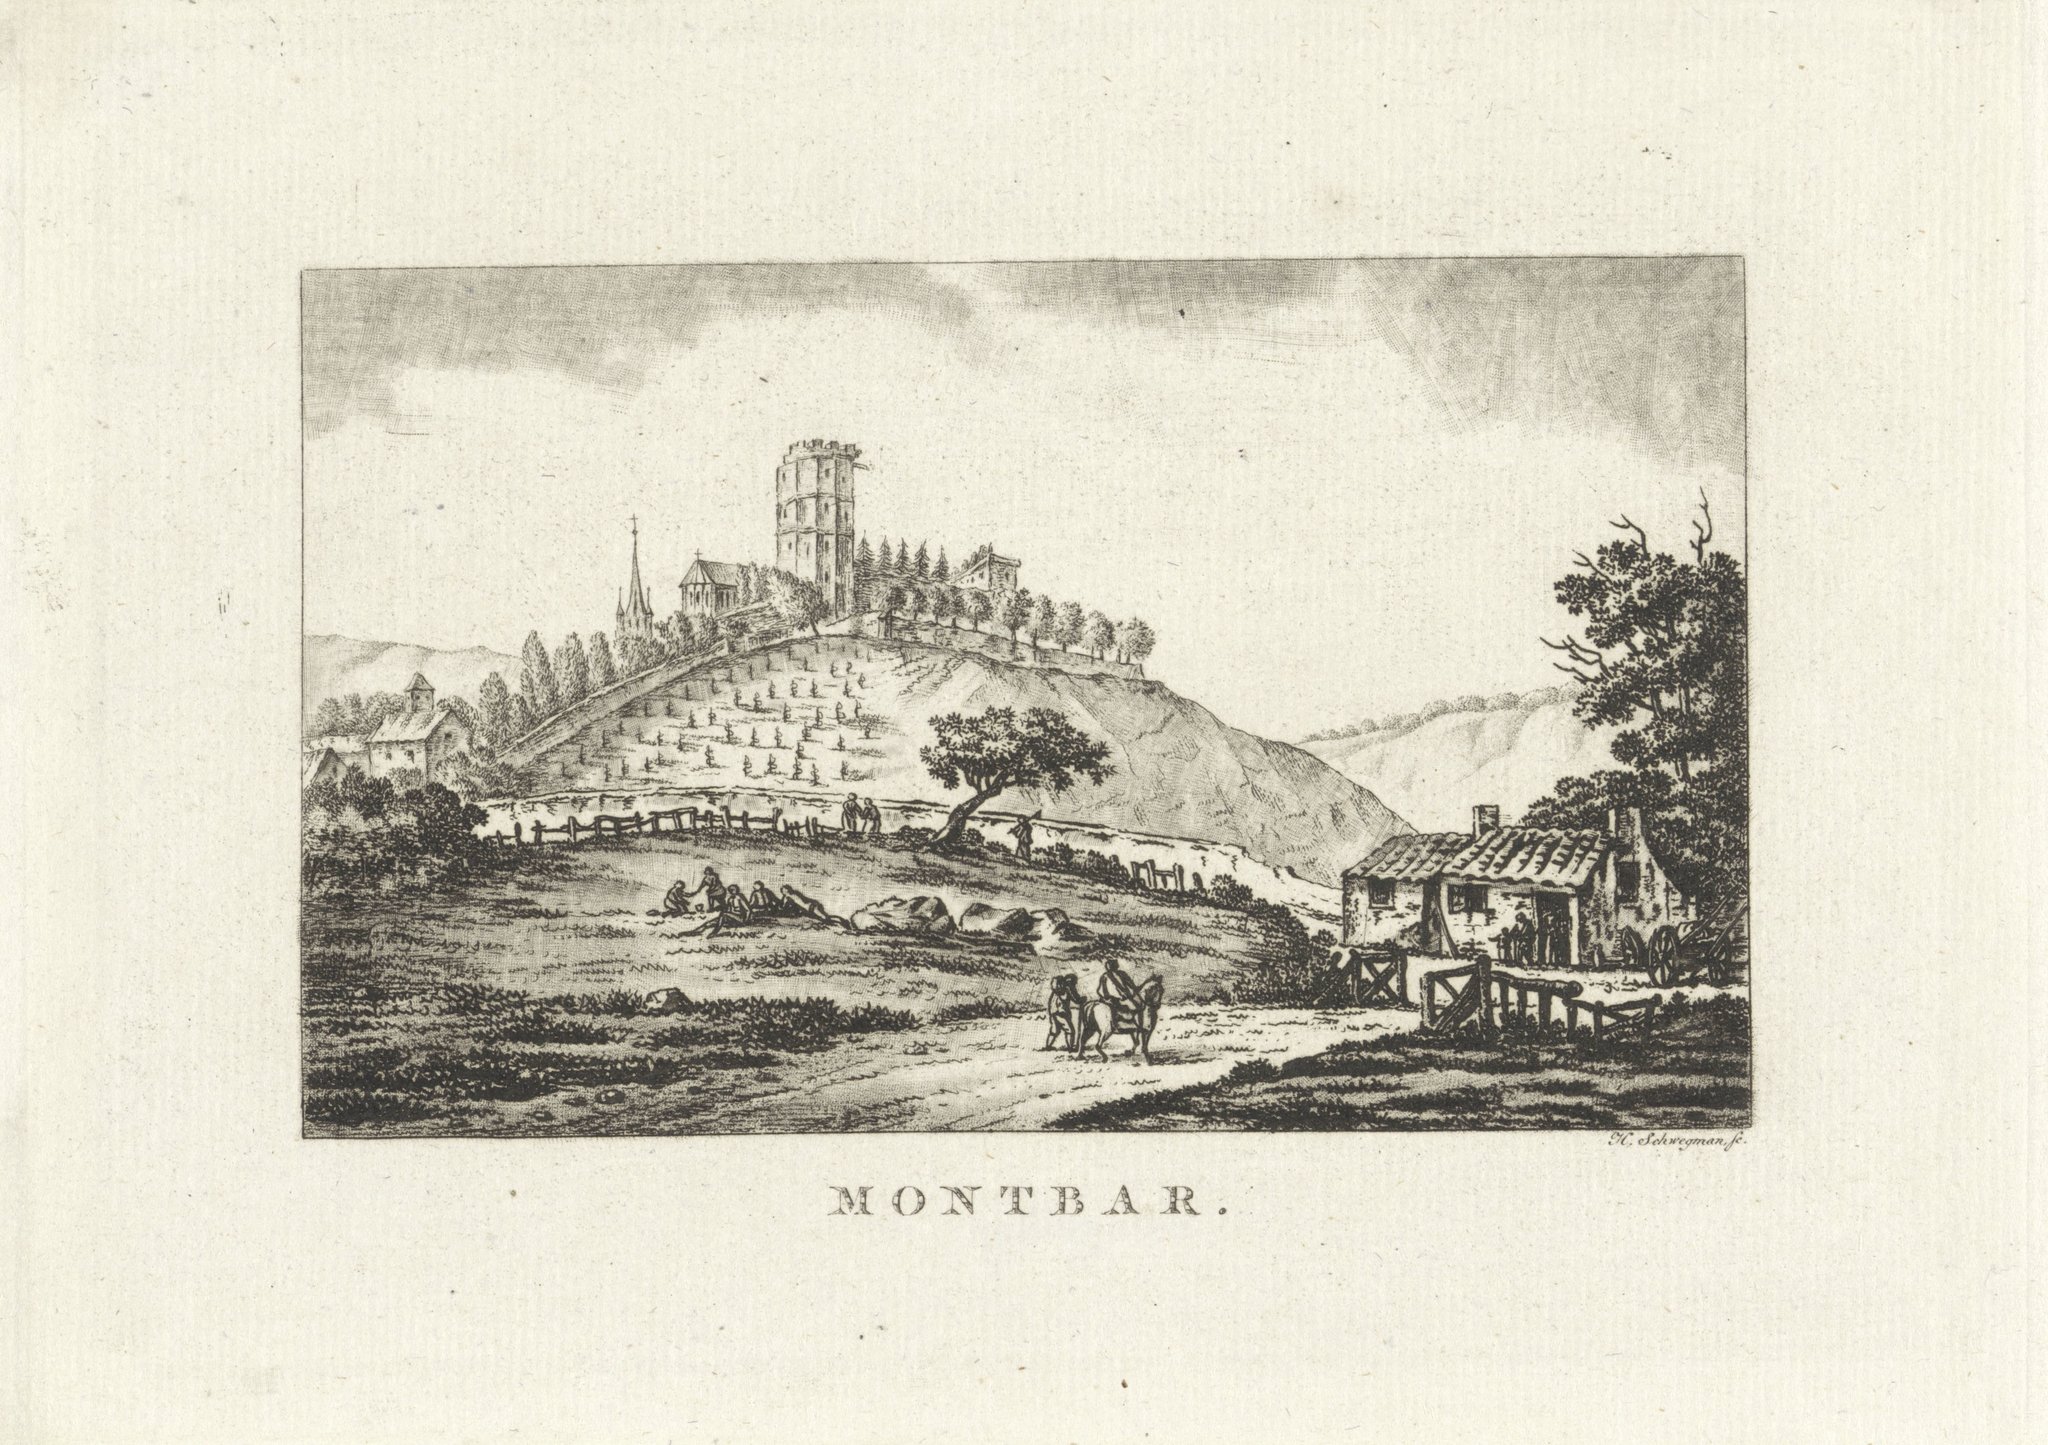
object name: print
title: Gezicht op Montbard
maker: hendrik schwegman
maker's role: draughtsman, print maker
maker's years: 1761-1816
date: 1771-1816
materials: paper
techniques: etching, roulette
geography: haarlem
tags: tower, clock tower ~ monumental adornment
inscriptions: collector's mark: Lugt 2228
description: Gezicht op Montbard en toren van l´Aubespin op de heuvel.